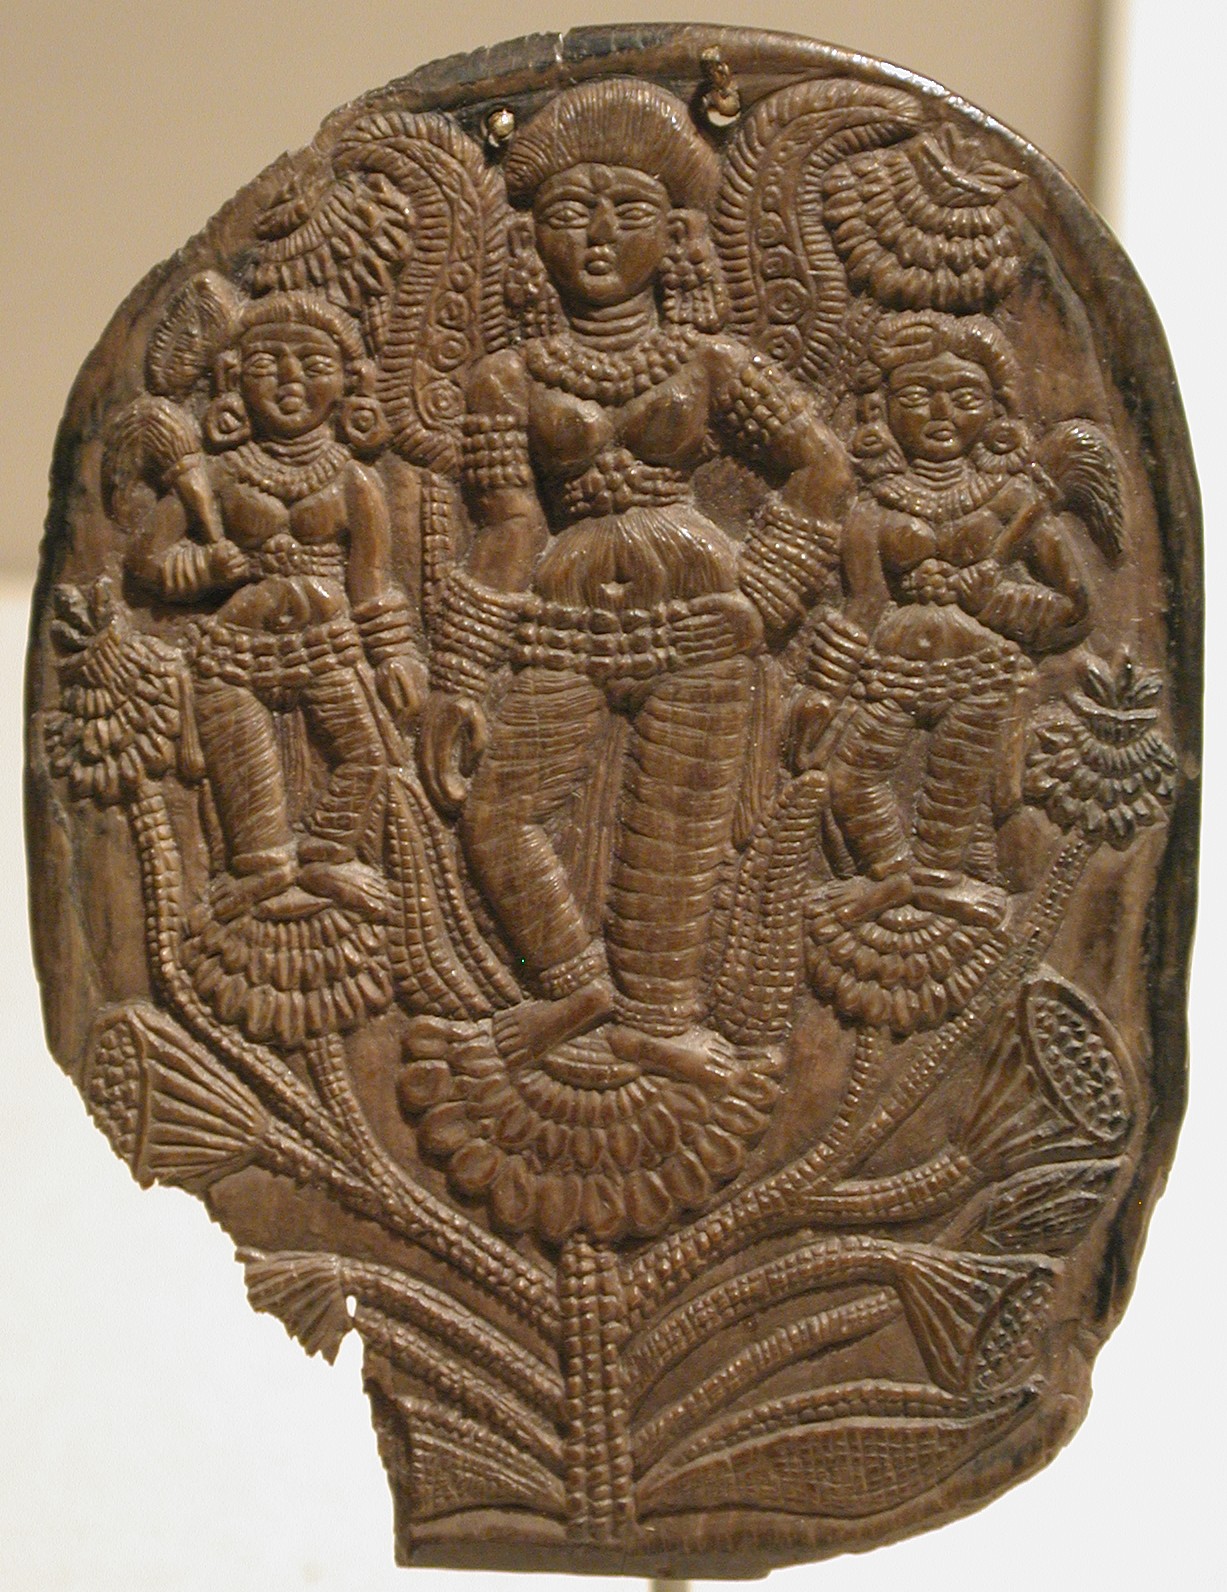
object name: plaque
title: Plaque with a Winged Goddess and Two Attendants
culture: indian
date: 100-1 BCE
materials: ivory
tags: goddess